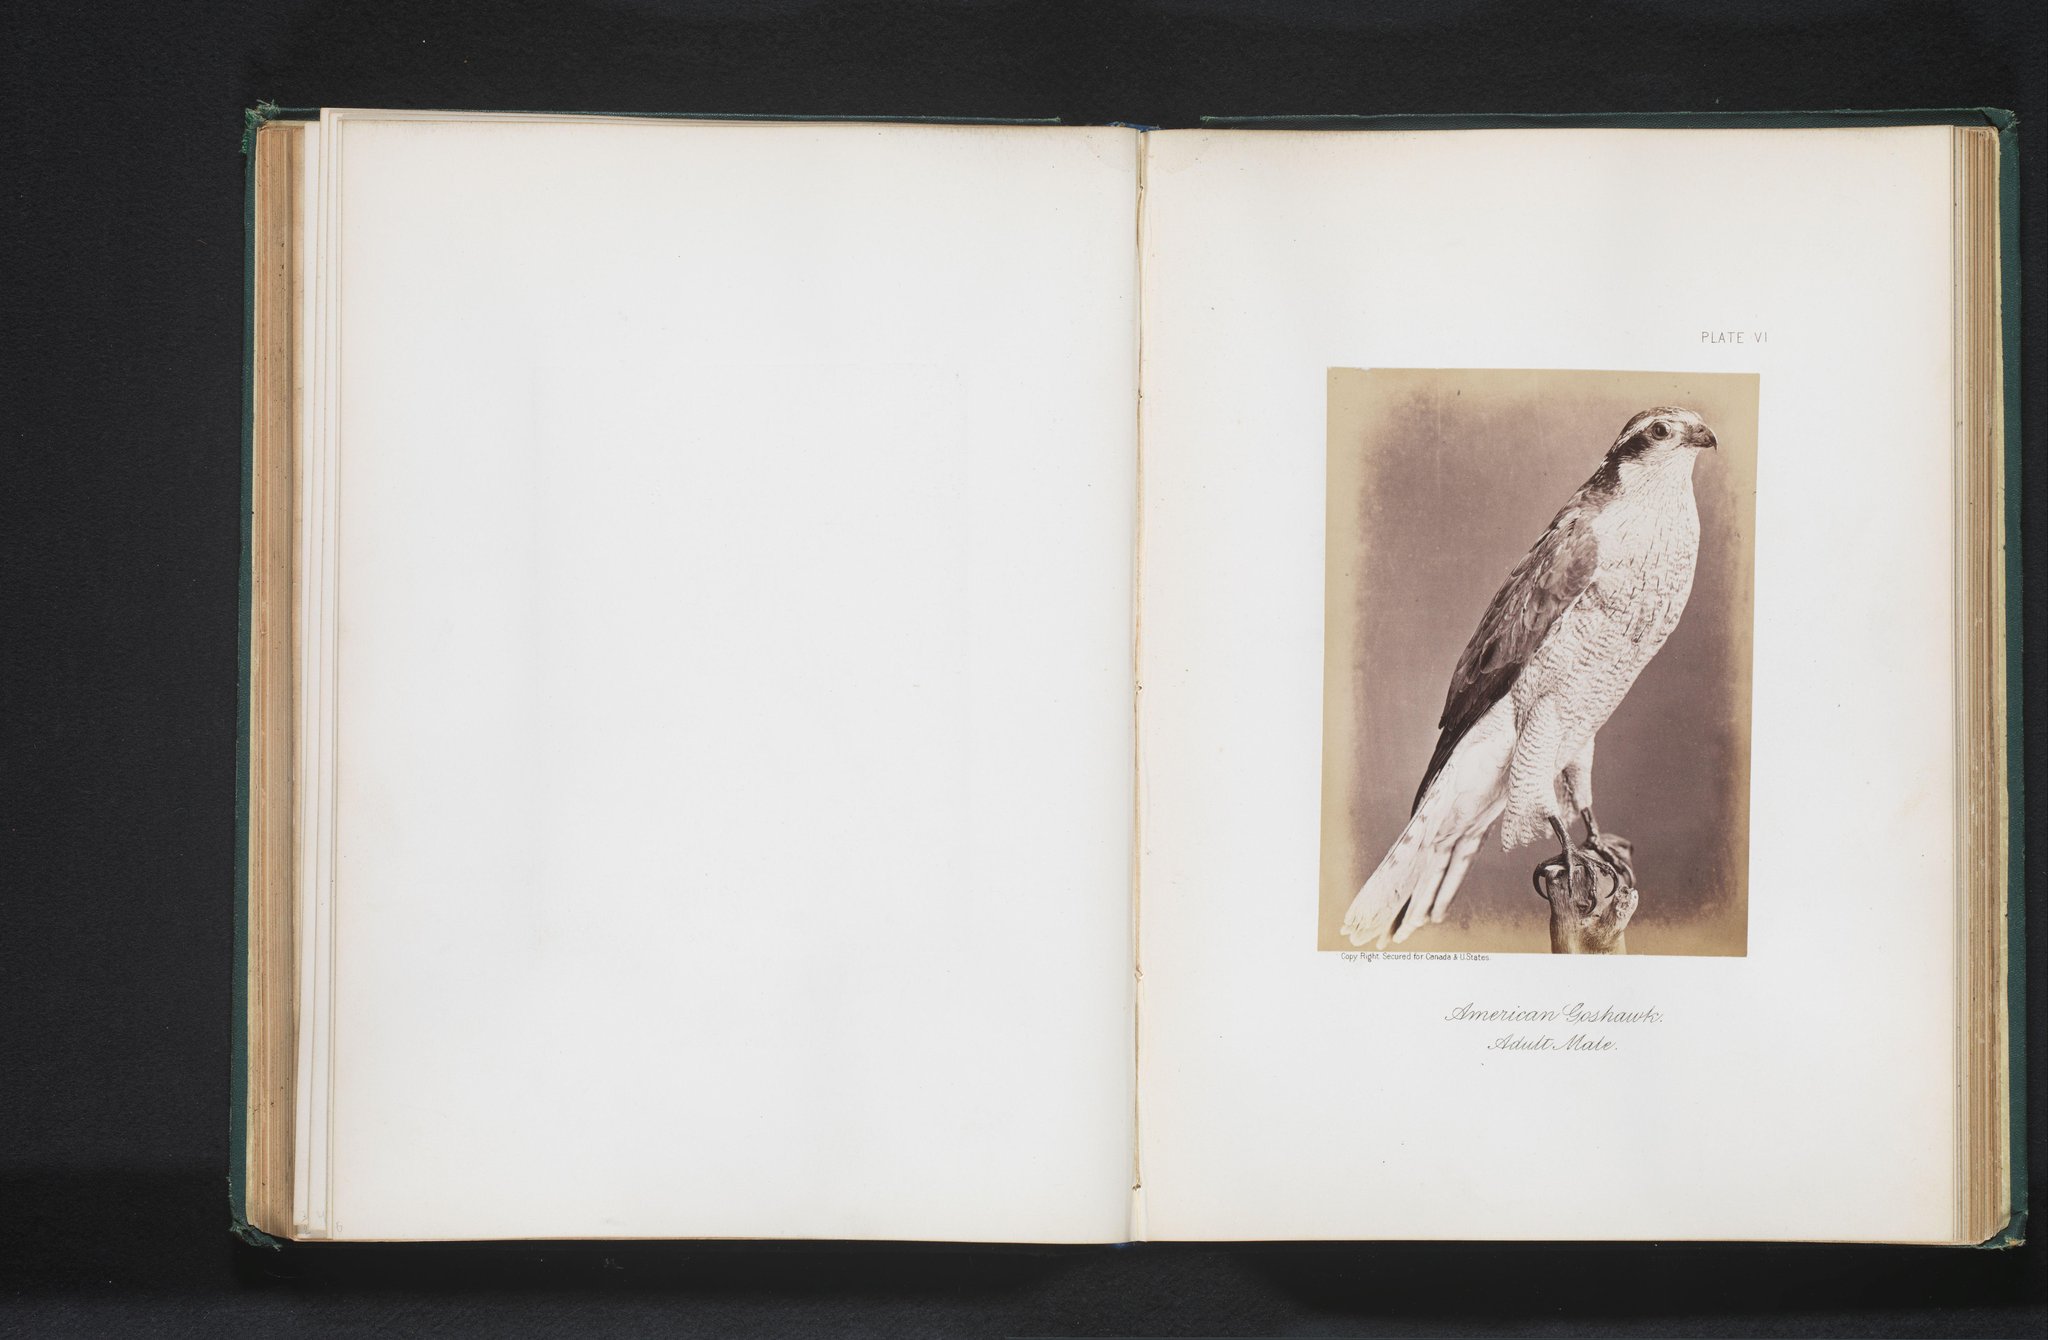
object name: photograph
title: American Goshawk. Adult Male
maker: william notman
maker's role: fotograaf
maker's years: 1826-1891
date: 1871-1876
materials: paper, photographic support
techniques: albumen print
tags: collection of animals, predatory birds: hawk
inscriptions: number: ‘PLATE VI’, inscription: ‘Copy Right Secured for Canada & U.States’